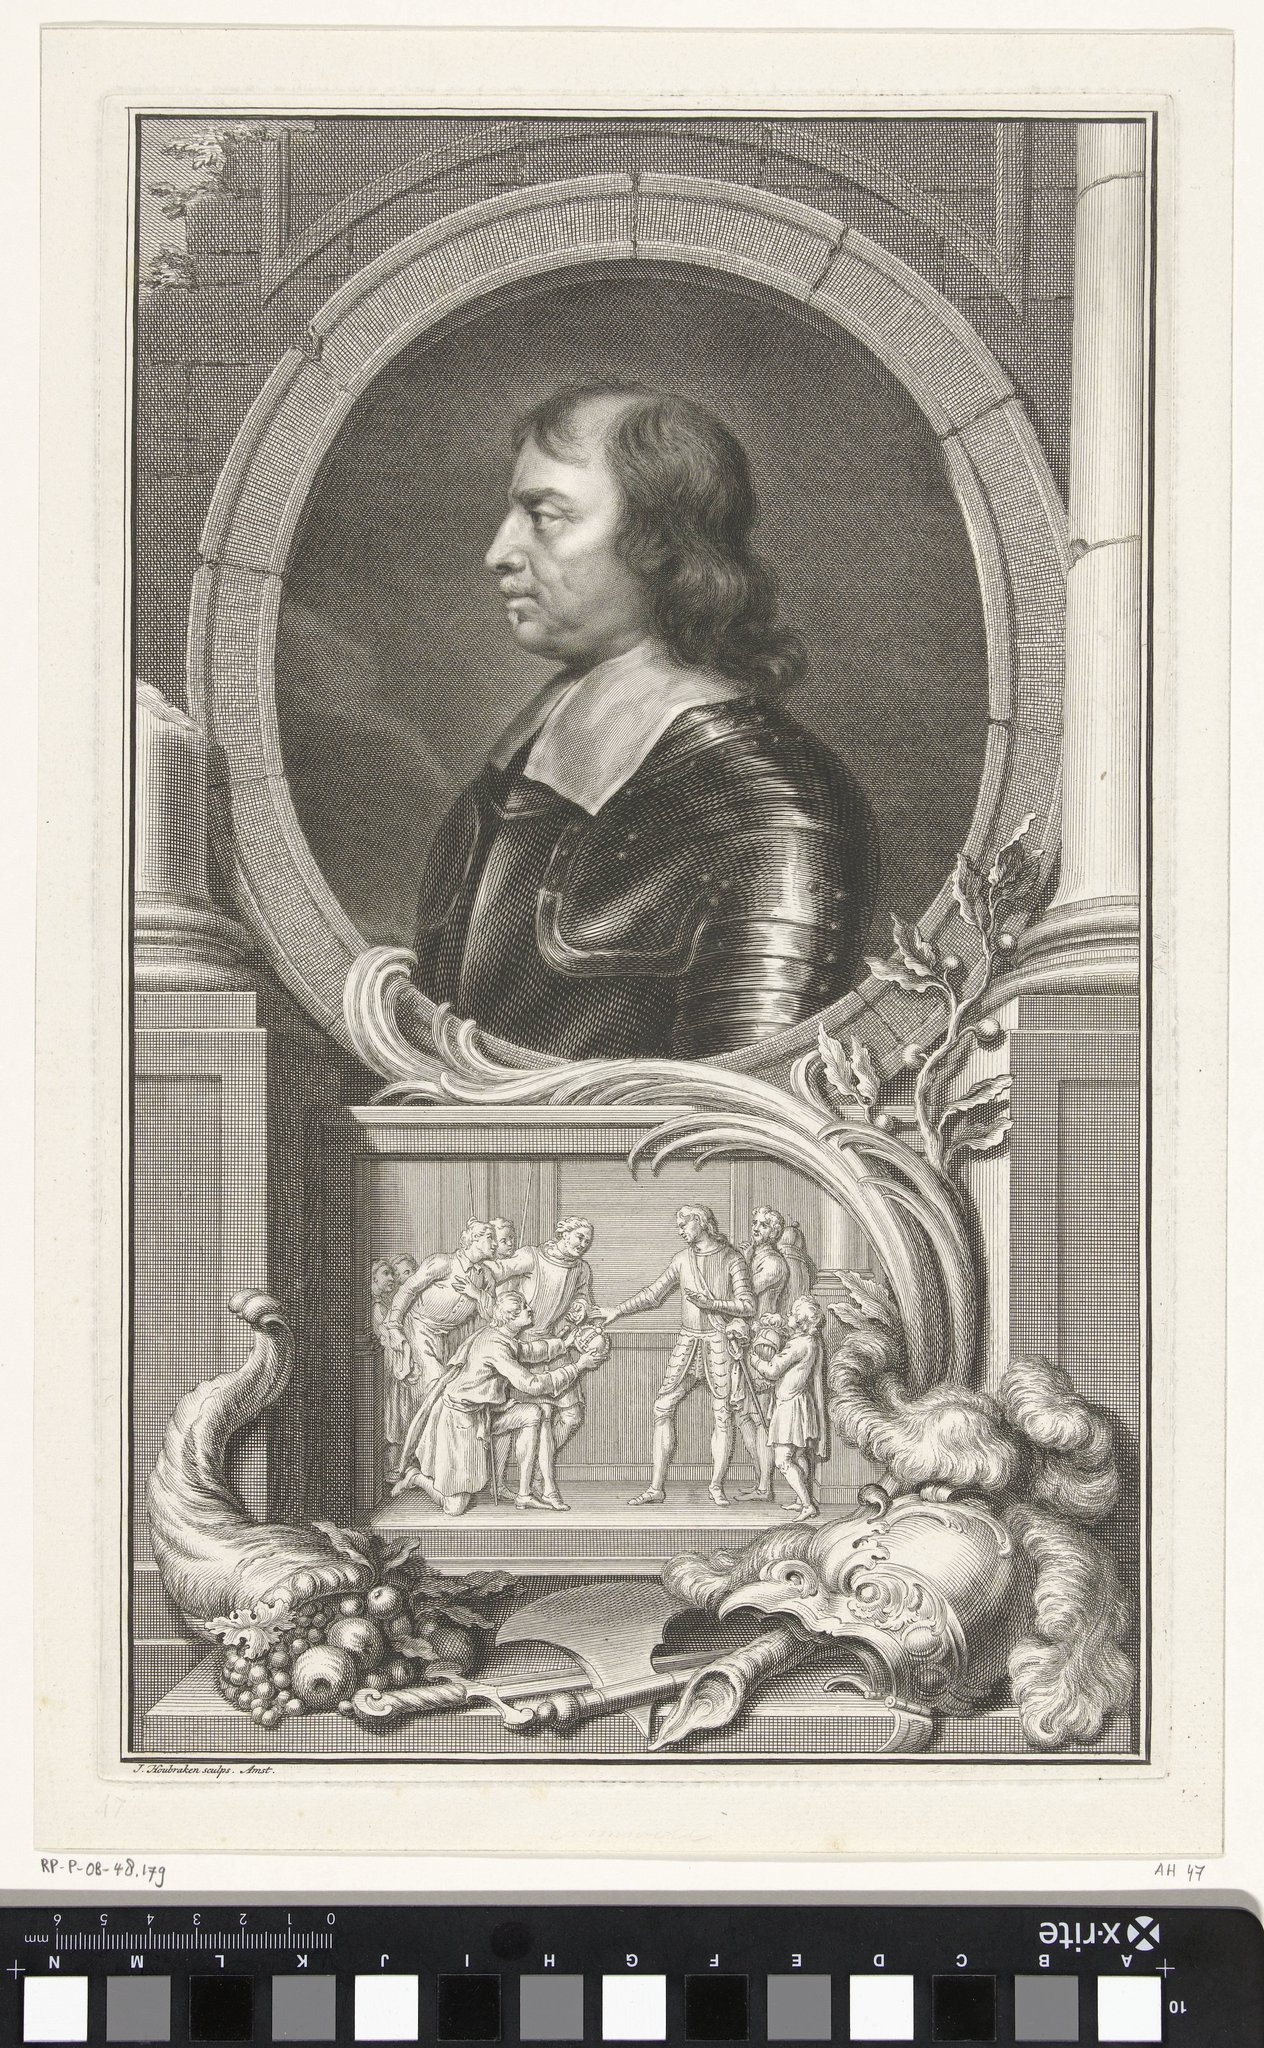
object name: print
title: Portret van Oliver Cromwell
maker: jacob houbraken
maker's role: draughtsman, print maker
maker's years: 1698-1780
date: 1741-1743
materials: paper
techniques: engraving, etching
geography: amsterdam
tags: oliver cromwell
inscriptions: collector's mark: Lugt 240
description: Prent ook gebruikt in: Thomas Birch. The heads of illustrious persons of Great Britain : engraved by Houbraken, and Vertue, with their lives and characters. London: John en Paul Knapton, 1743-1751.